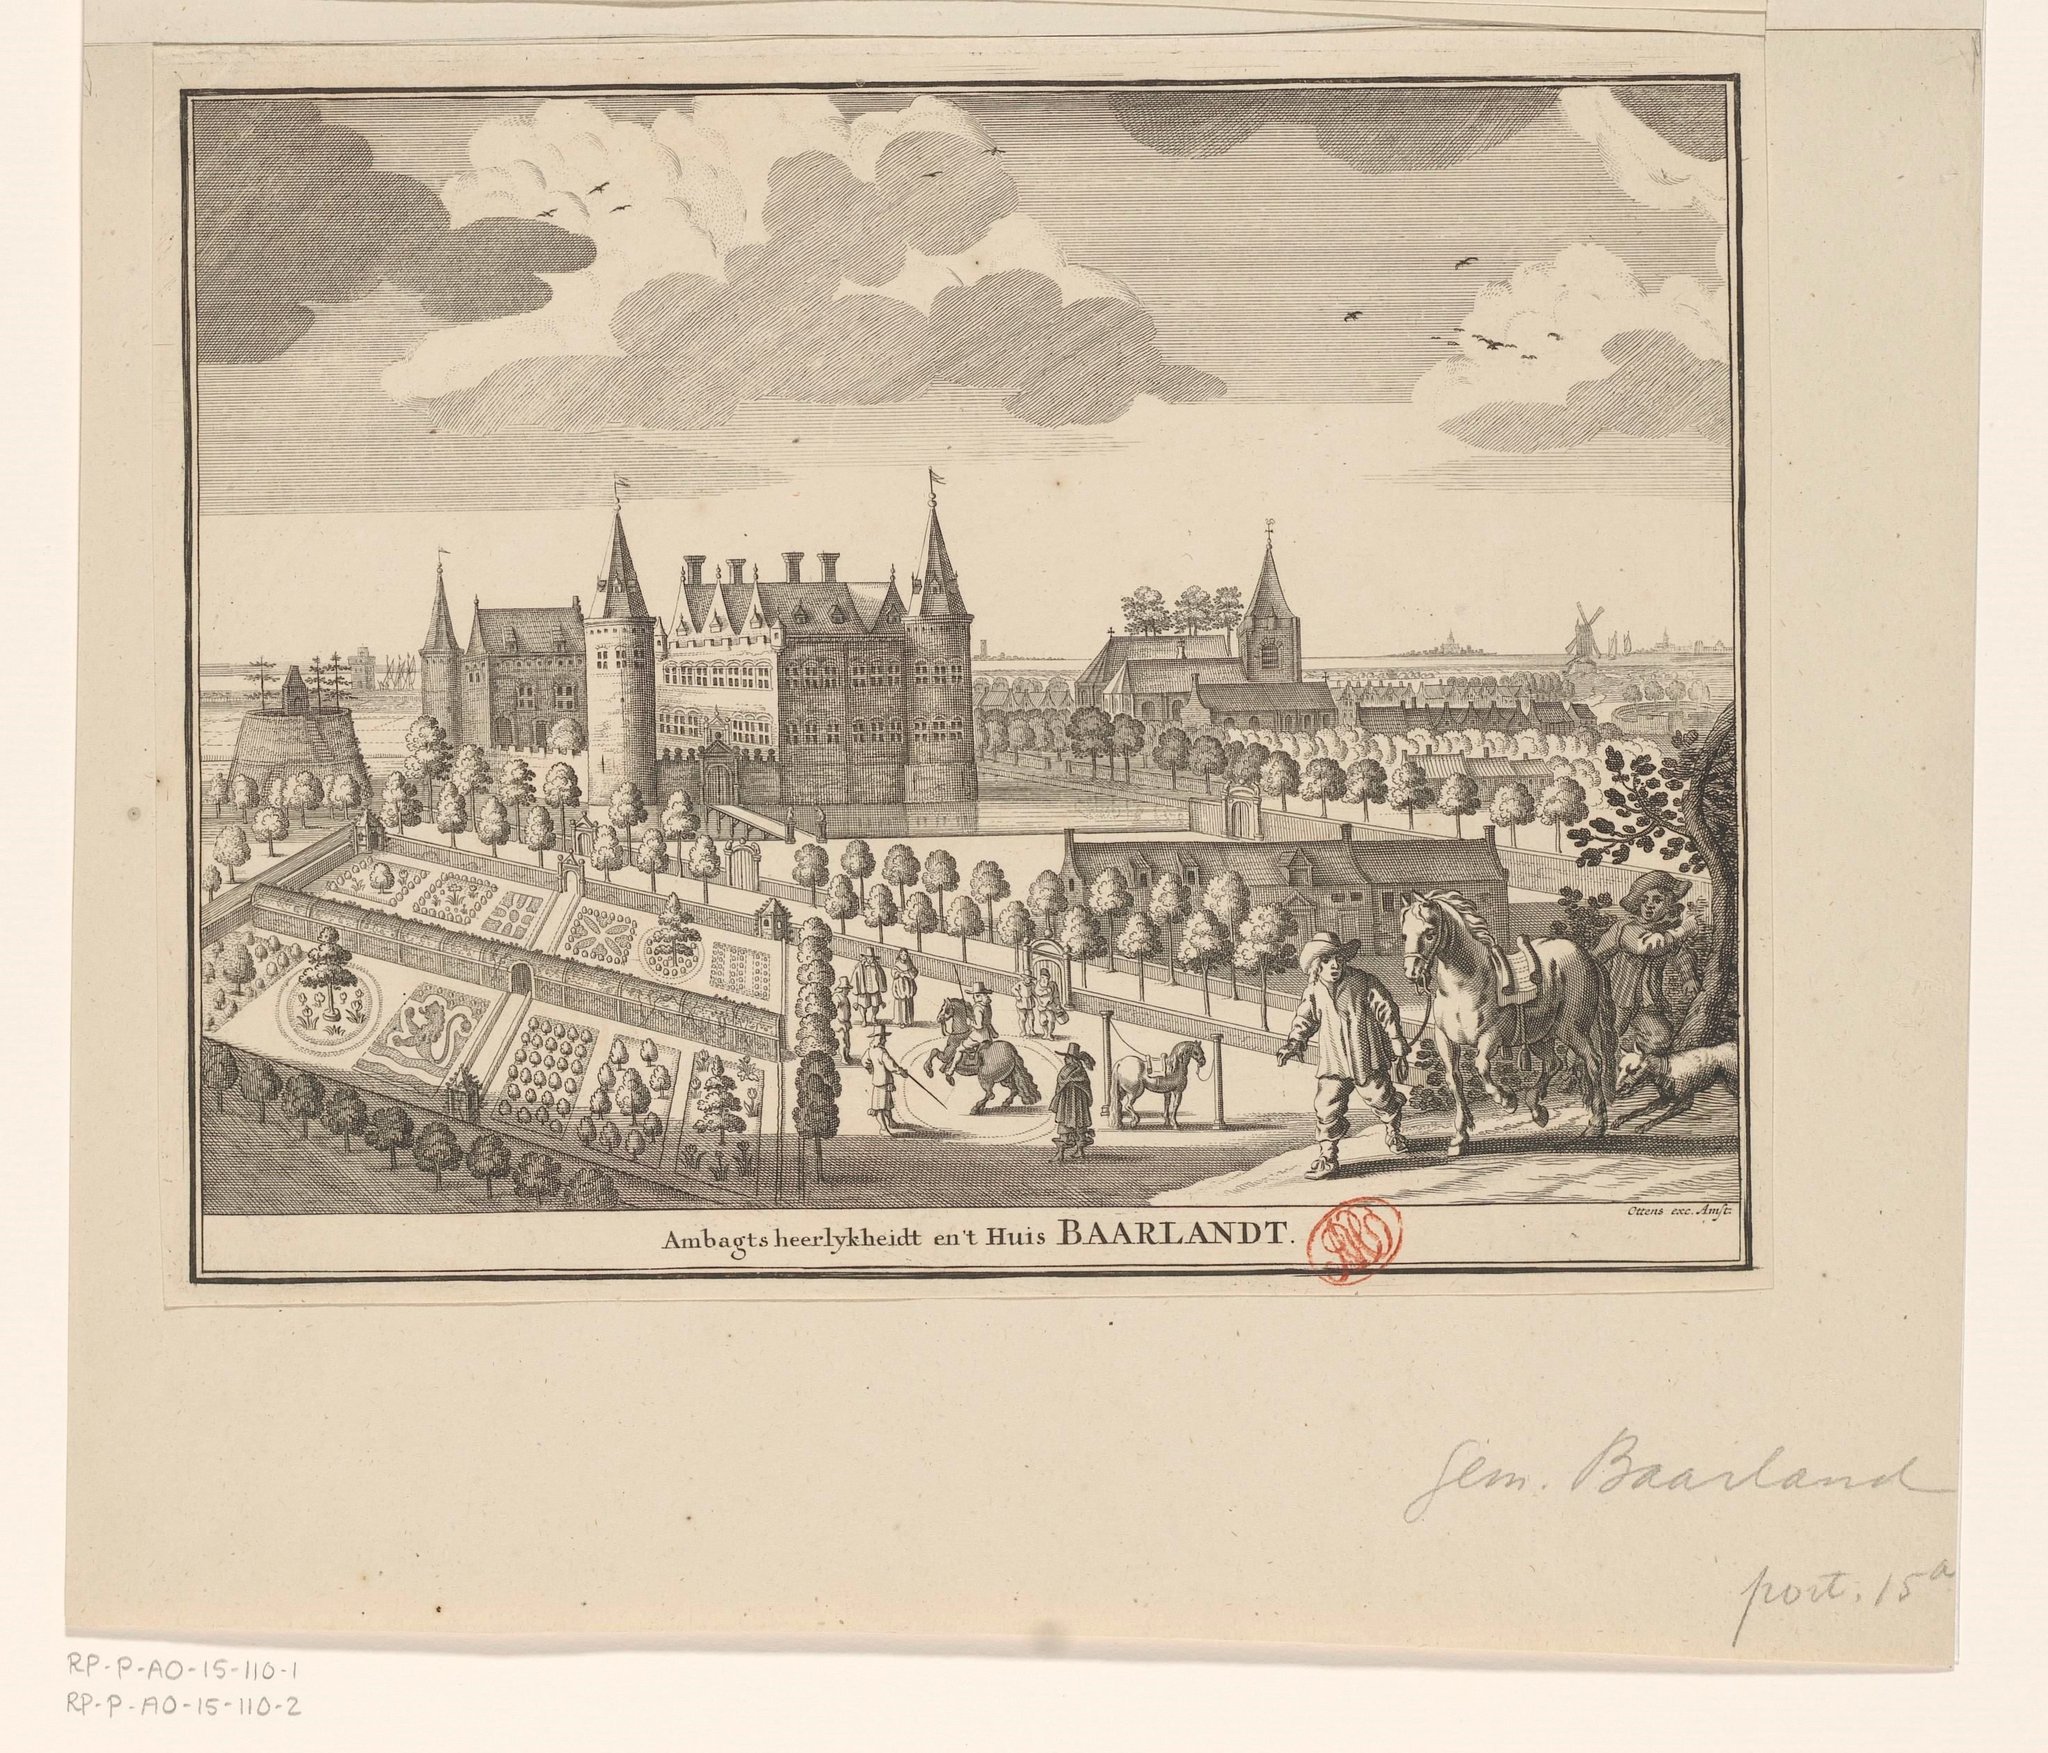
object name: print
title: Gezicht op Slot Baarland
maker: pieter hendricksz. schut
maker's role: print maker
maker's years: 1618-1660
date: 1657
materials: paper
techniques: engraving, etching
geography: amsterdam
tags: prospect of village, silhouette of village, castle, garden, church (exterior), training of horses, coat of arms (as symbol of the state, etc.) (+ province; provincial)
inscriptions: collector's mark: Lugt 195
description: Prent ook gebruikt in: Speculum Zelandiae dat is een beschryvinge ofte afbeelding der steden, ambachts-heerlijckheden, dorpen castelen, ridderlijcke hofsteden, huysen en gebouwen gelegen inde eylanden en de graeflijckheyt van Zeelandt. Amsterdam: weduwe Ottens en Zoonen, s.a. [1719-1725]. Eerdere staat/staten van prent is/zijn gebruikt in eerdere uitgaven van 'Speculum Zelandiae' en in andere publicaties uitgegeven door Zacharias Roman en Nicolaes Visscher (I). De eerste publicatie waarin de eerste staat van de huidige prent voorkomt dateert uit 1657. Verwarring rondom de datering kan ontstaan door het feit de prenten uit 'Speculum Zelandiae' ook voorkomen in eerder uitgegeven publicaties, waar ze later in zijn ingebonden. Zo komen prenten uitgegeven door Roman/Visscher voor in sommige exemplaren van: Boxhorn, Marcus Zuerius van. Chroniick van Zeelandt (…). 2 delen. Middelburg: Zacharias Roman, 1644. De door weduwe (Joachim) Ottens en Zoonen uitgegeven prenten zijn later ingebonden in sommige exemplaren van: Smallegange, Mattheus. Nieuwe Cronyk van Zeeland (…). Middelburg en Amsterdam: Johannes Meertens en Abraham van Someren, 1696.